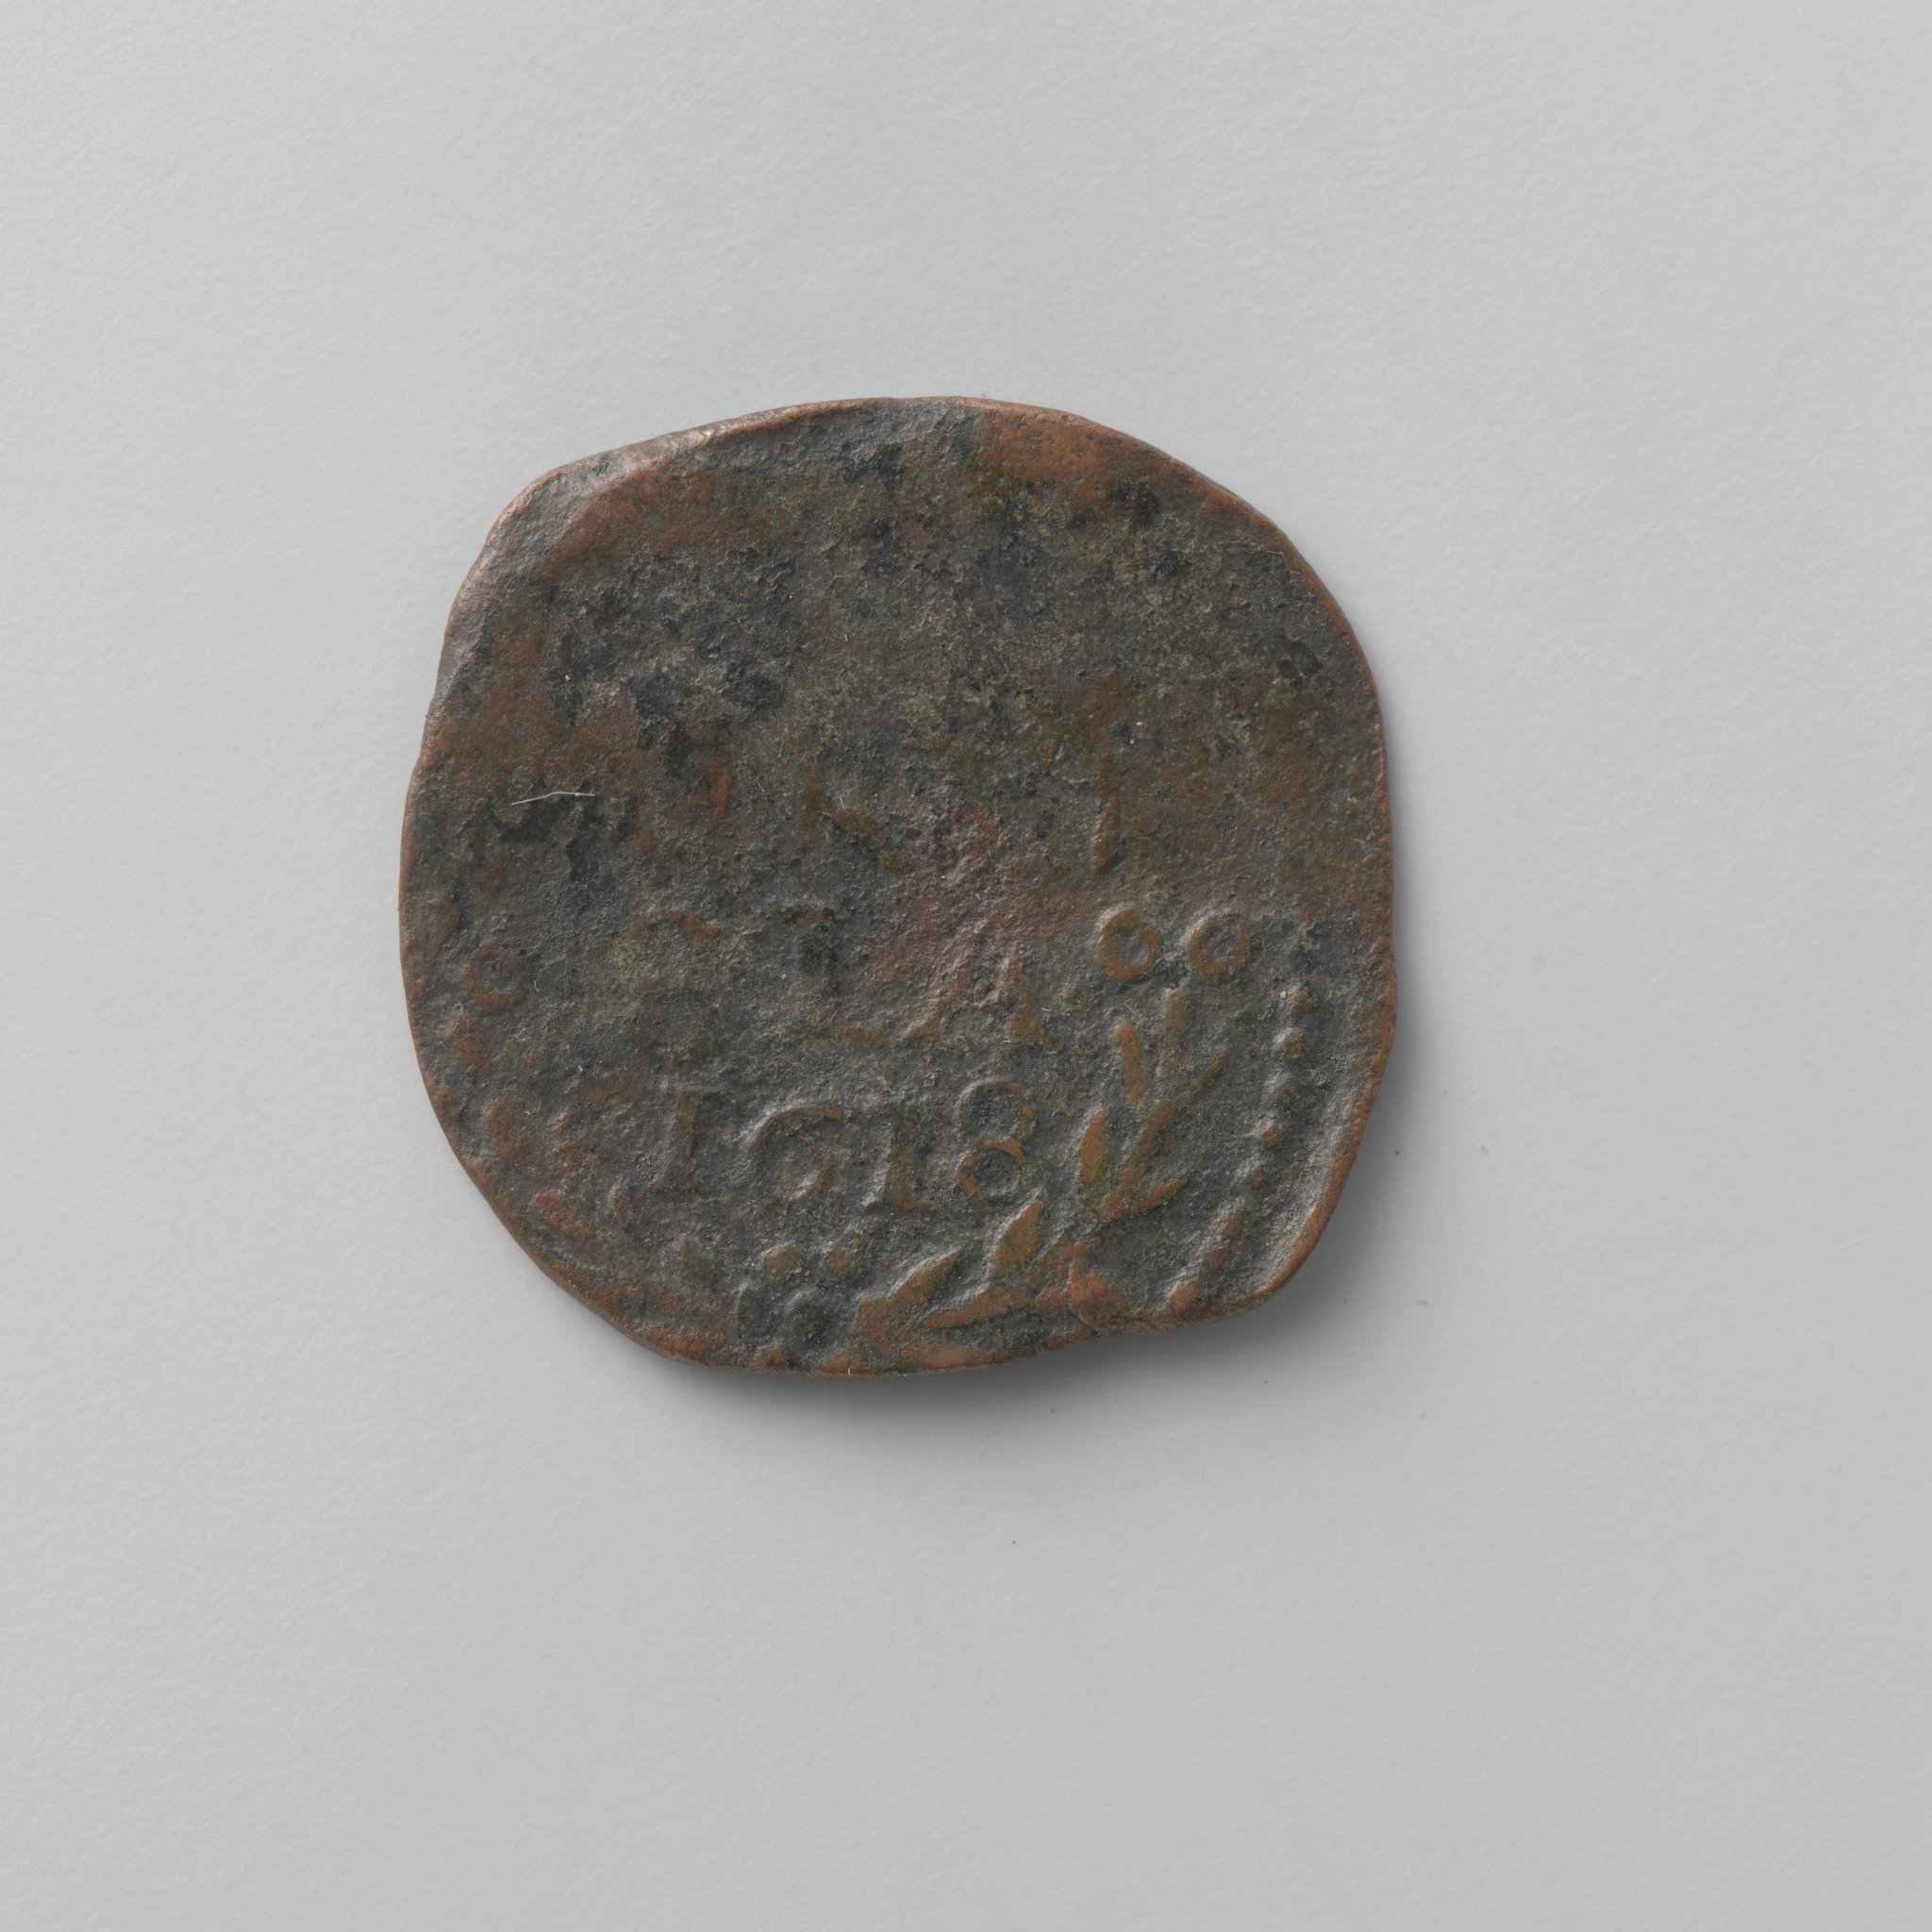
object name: coin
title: Friesland, duit, 1618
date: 1618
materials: copper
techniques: striking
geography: leeuwarden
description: Koperen munt. Voorzijde: gekroond en versierd wapenschild van Friesland. Keerzijde: in een bladerkrans opschrift in twee regels, waaronder jaartal.